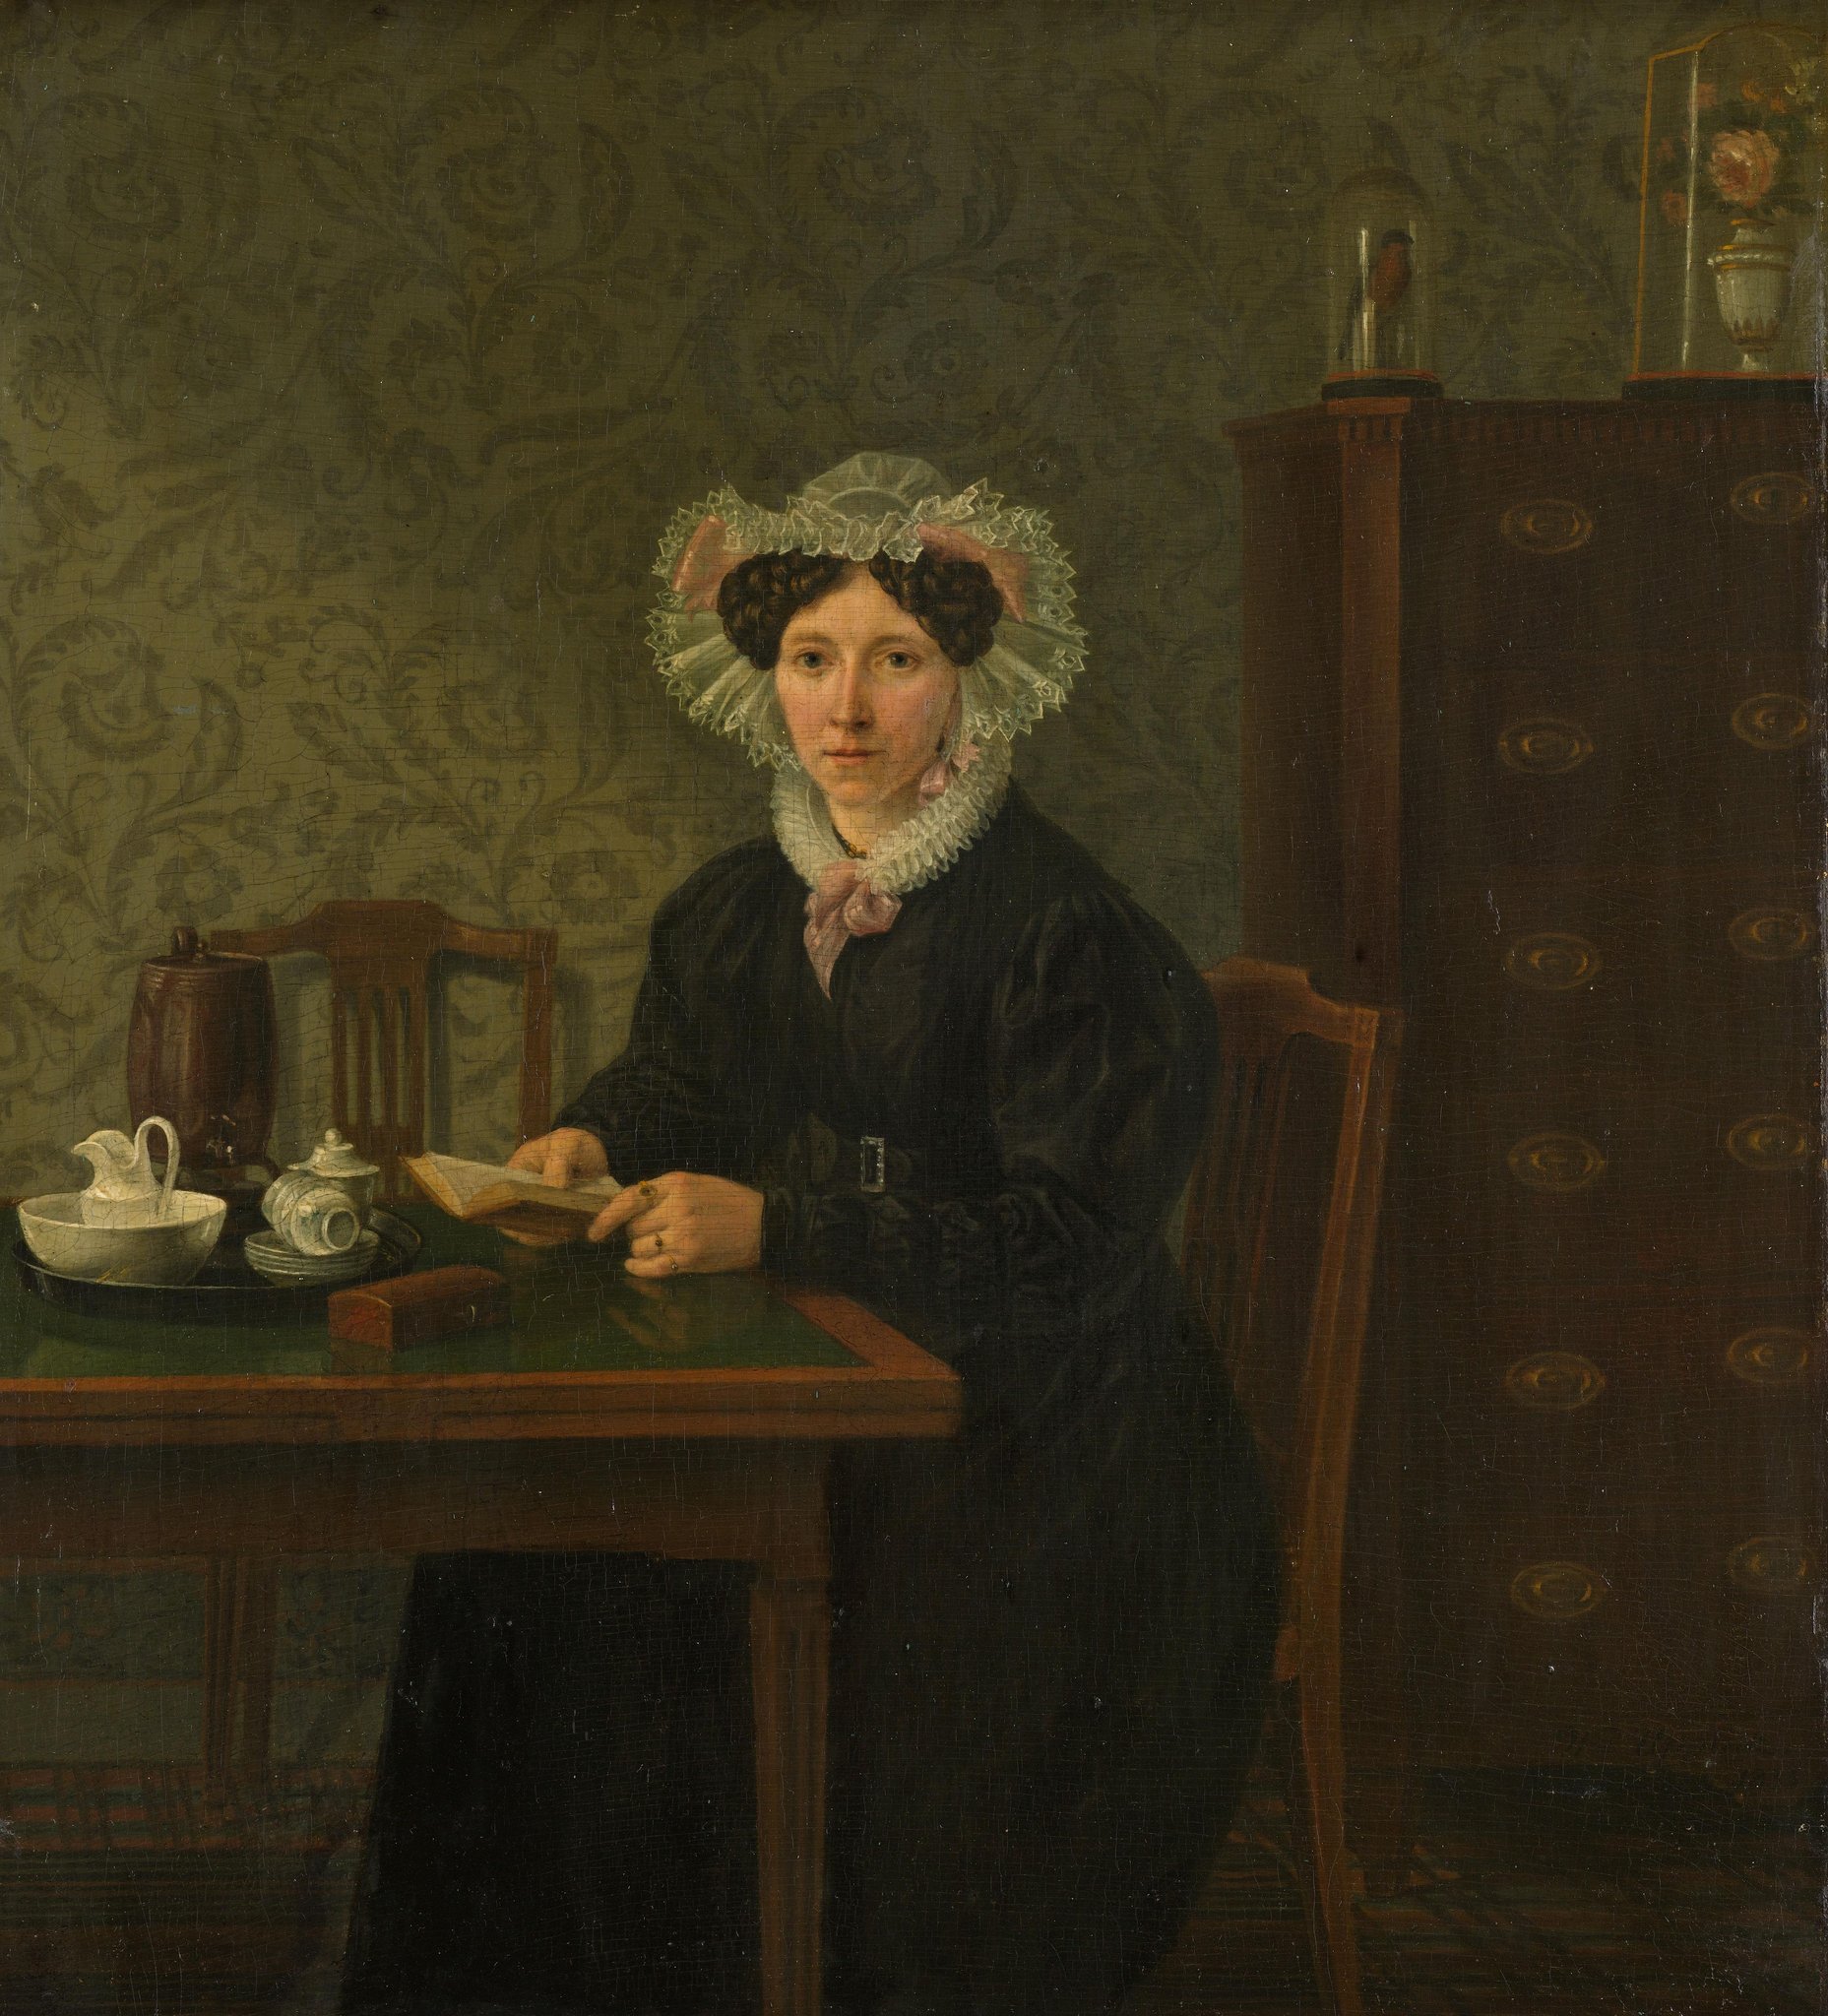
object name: painting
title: Portrait of a Woman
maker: willem uppink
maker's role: draughtsman, painter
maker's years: 1767-1849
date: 1833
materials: oil, panel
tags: anonymous historical person portrayed - bb - woman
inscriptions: signature and date: ‘Wm Uppink 1833’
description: Portret van een vrouw zittend aan een tafel met een boek in de handen. Op tafel staat een koffie- of theeservies, rechts een ladenkast met bovenop een bloemstuk en een opgezette vogel onder een glazen stolp.